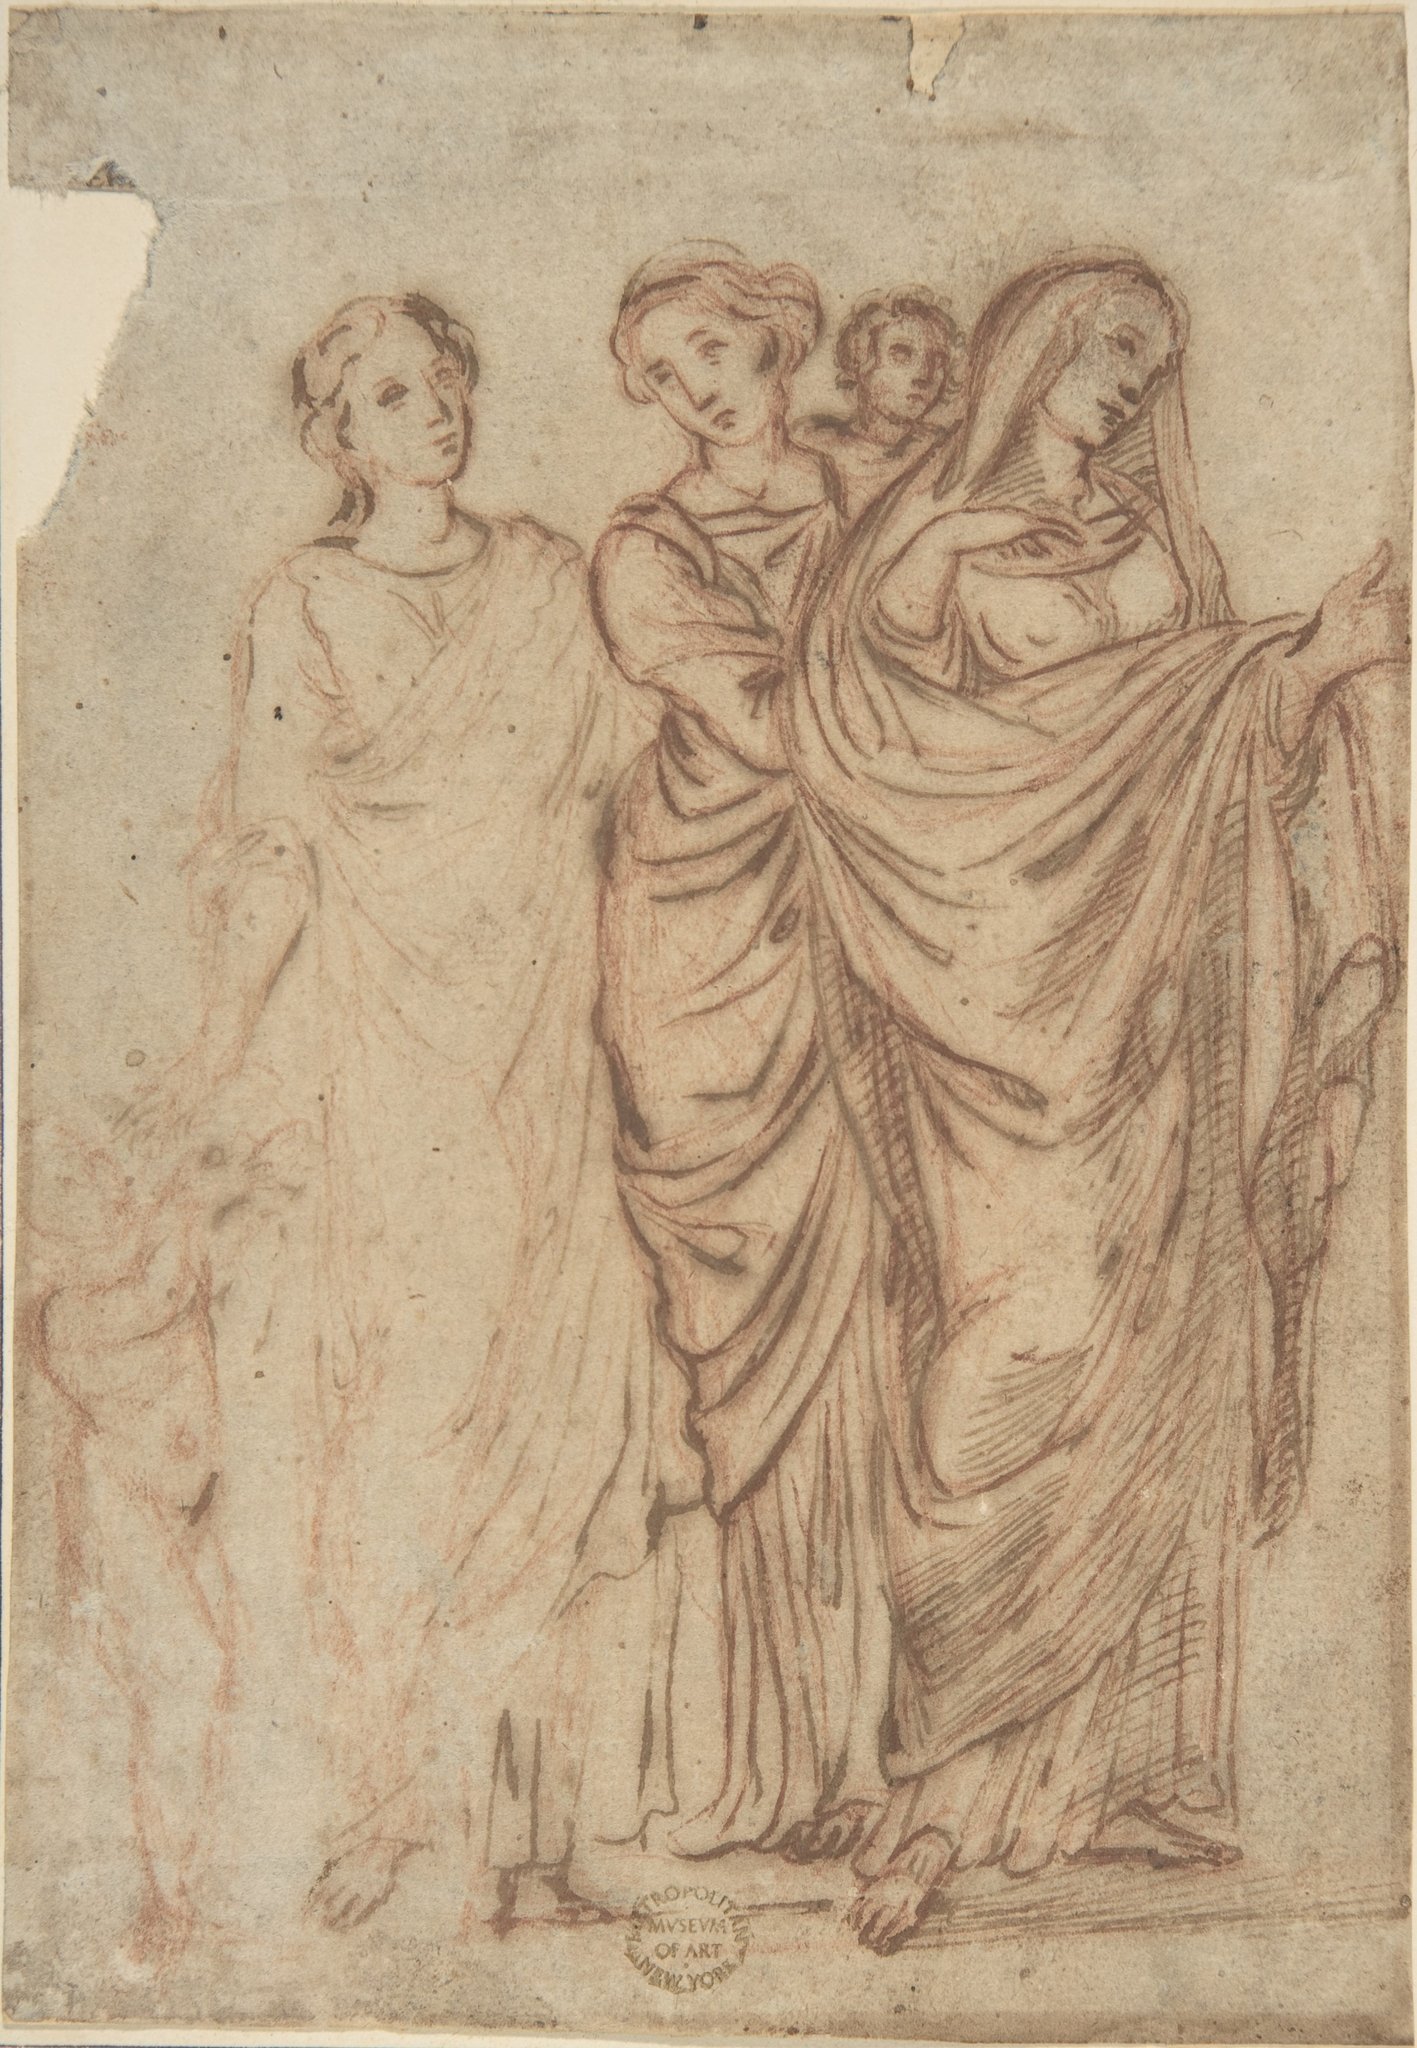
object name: drawing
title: Group of Women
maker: anonymous, italian, 17th or 18th century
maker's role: artist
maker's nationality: italian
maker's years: 1600-1799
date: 1701-1800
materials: chalk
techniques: pen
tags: women